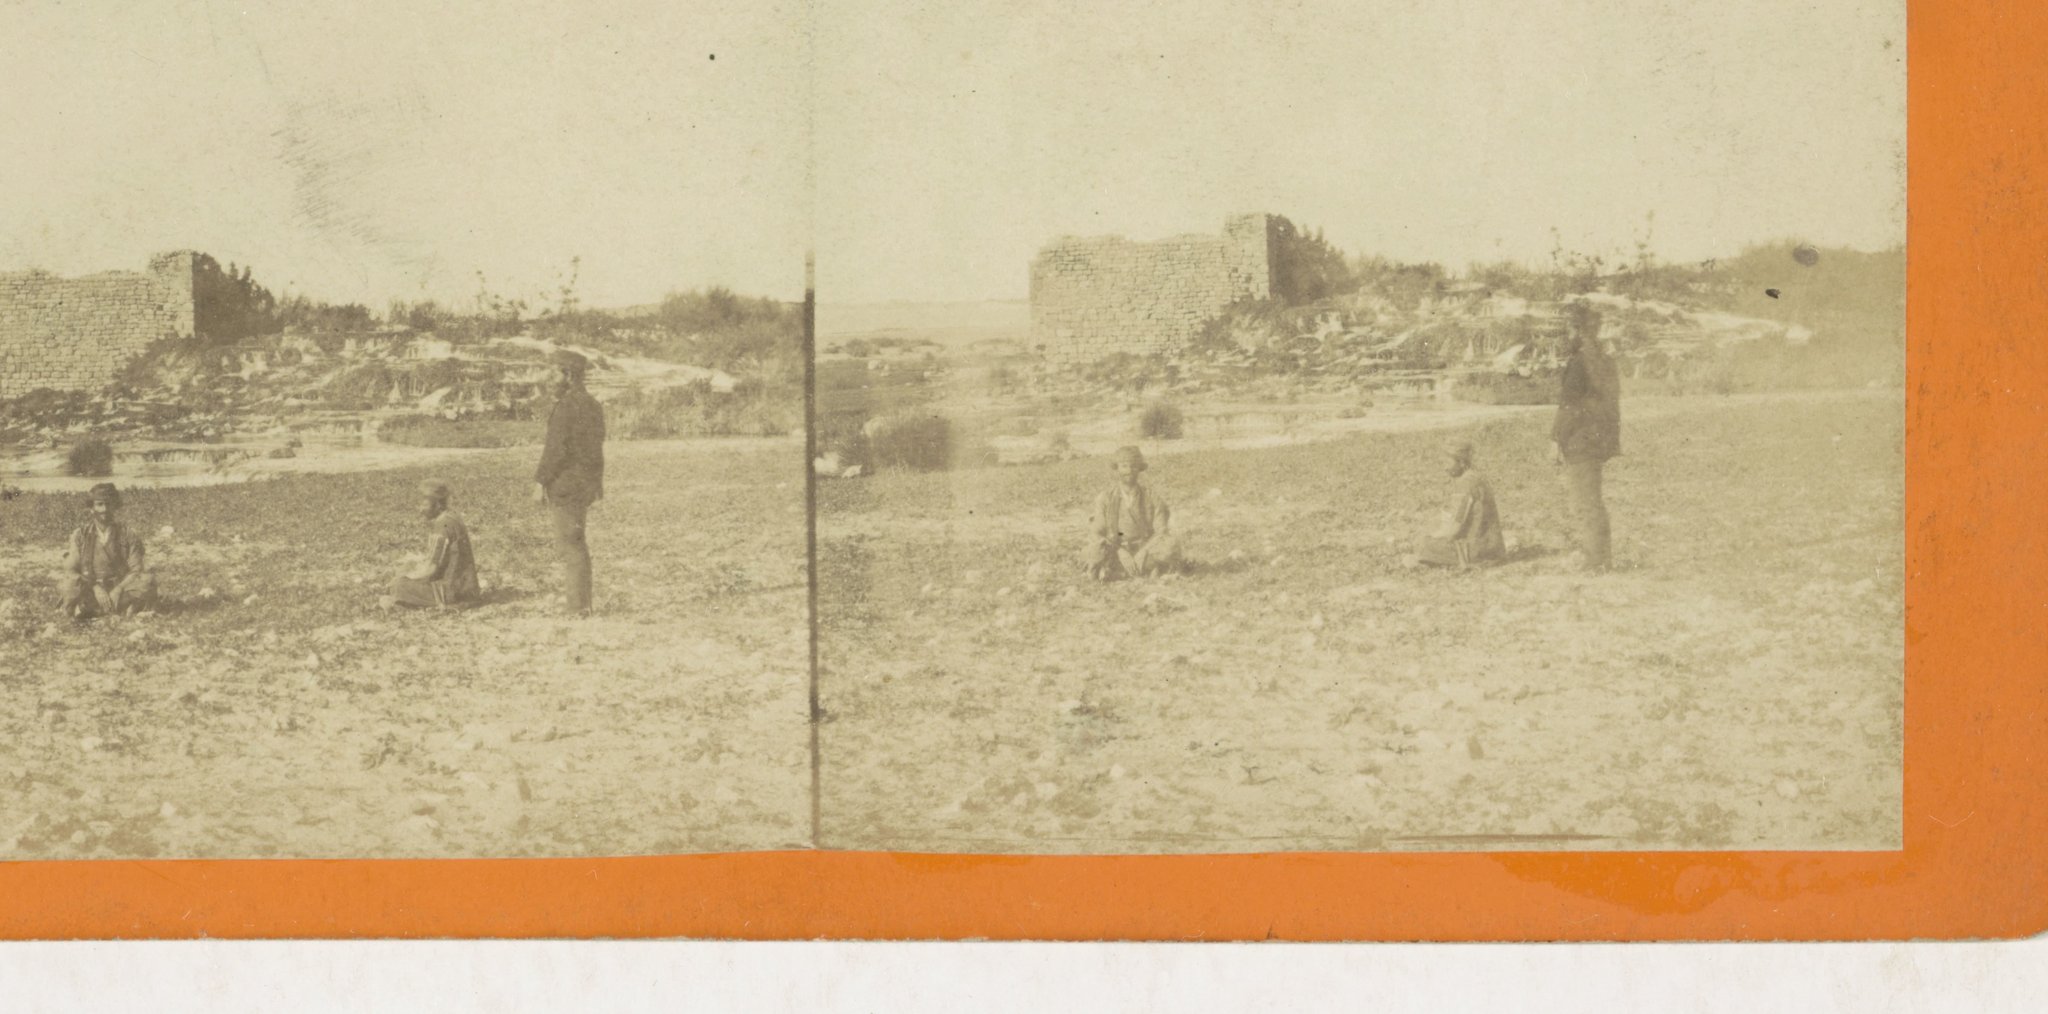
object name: stereograph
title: Waterbron van Salomon nabij Tyrus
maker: Anonymous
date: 1868-1890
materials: cardboard, paper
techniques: albumen print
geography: tyrus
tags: landscape with ruins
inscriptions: monogram: ‘DB/ R’